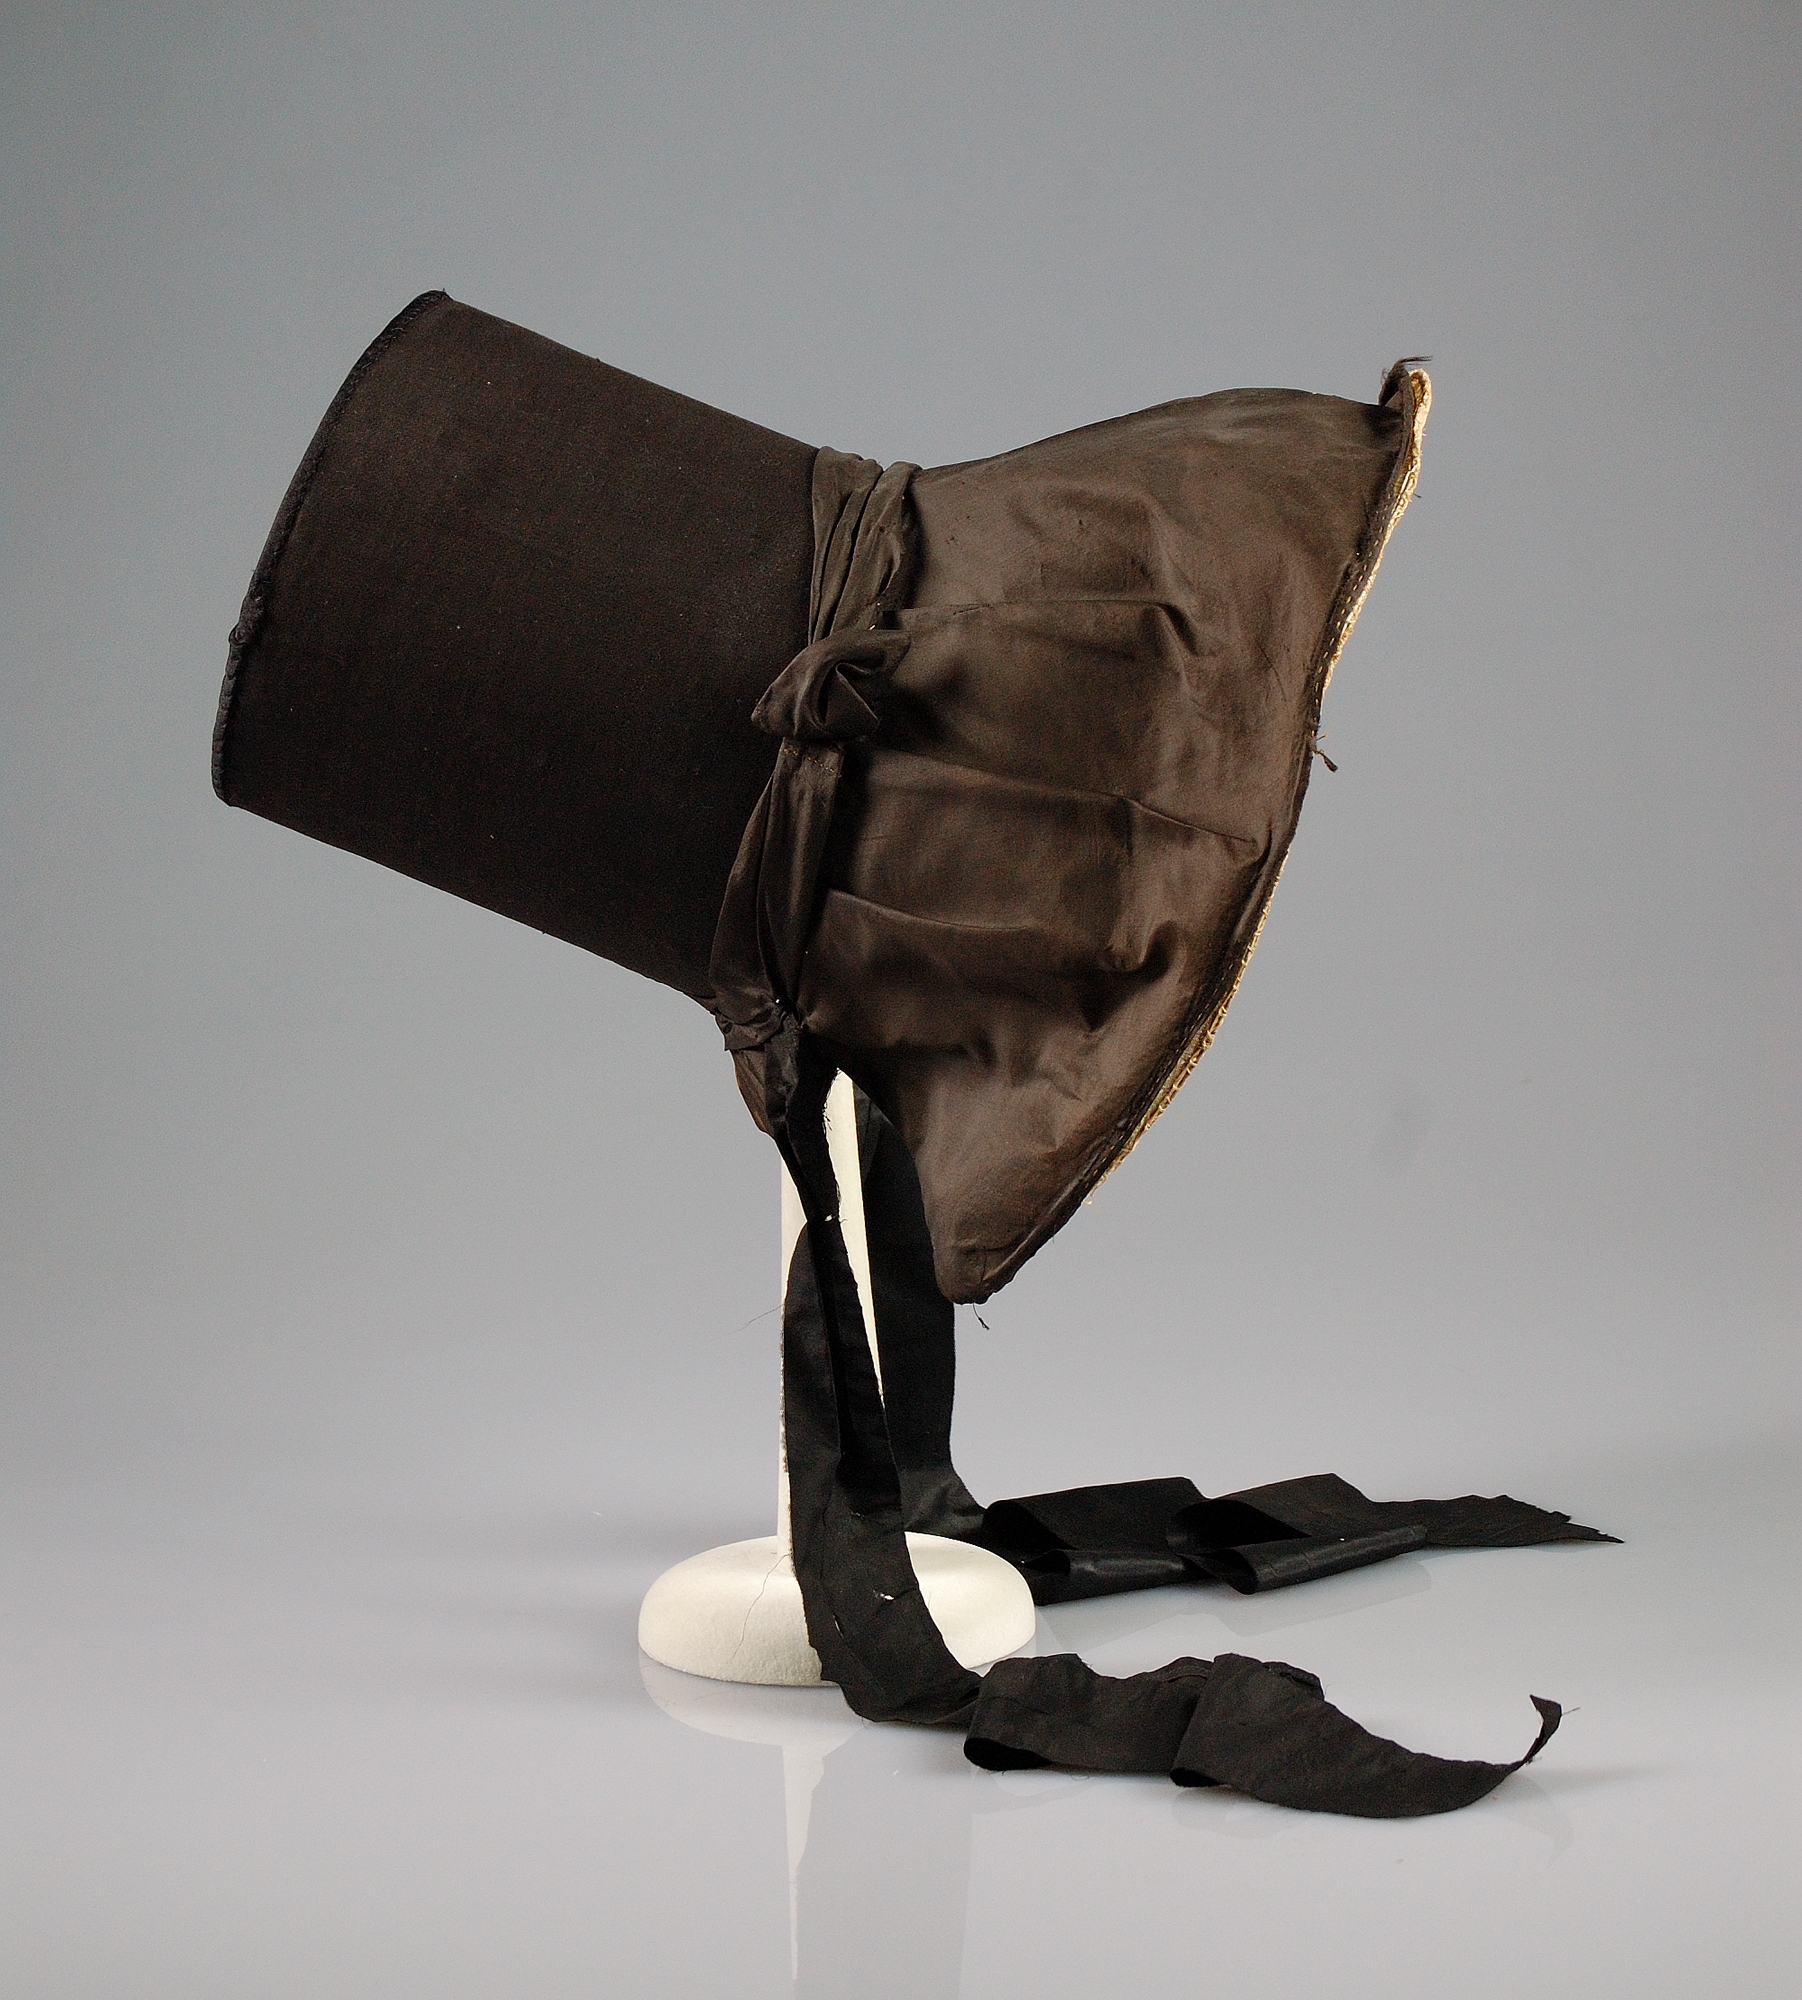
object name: bonnet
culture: american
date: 1815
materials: cotton, silk